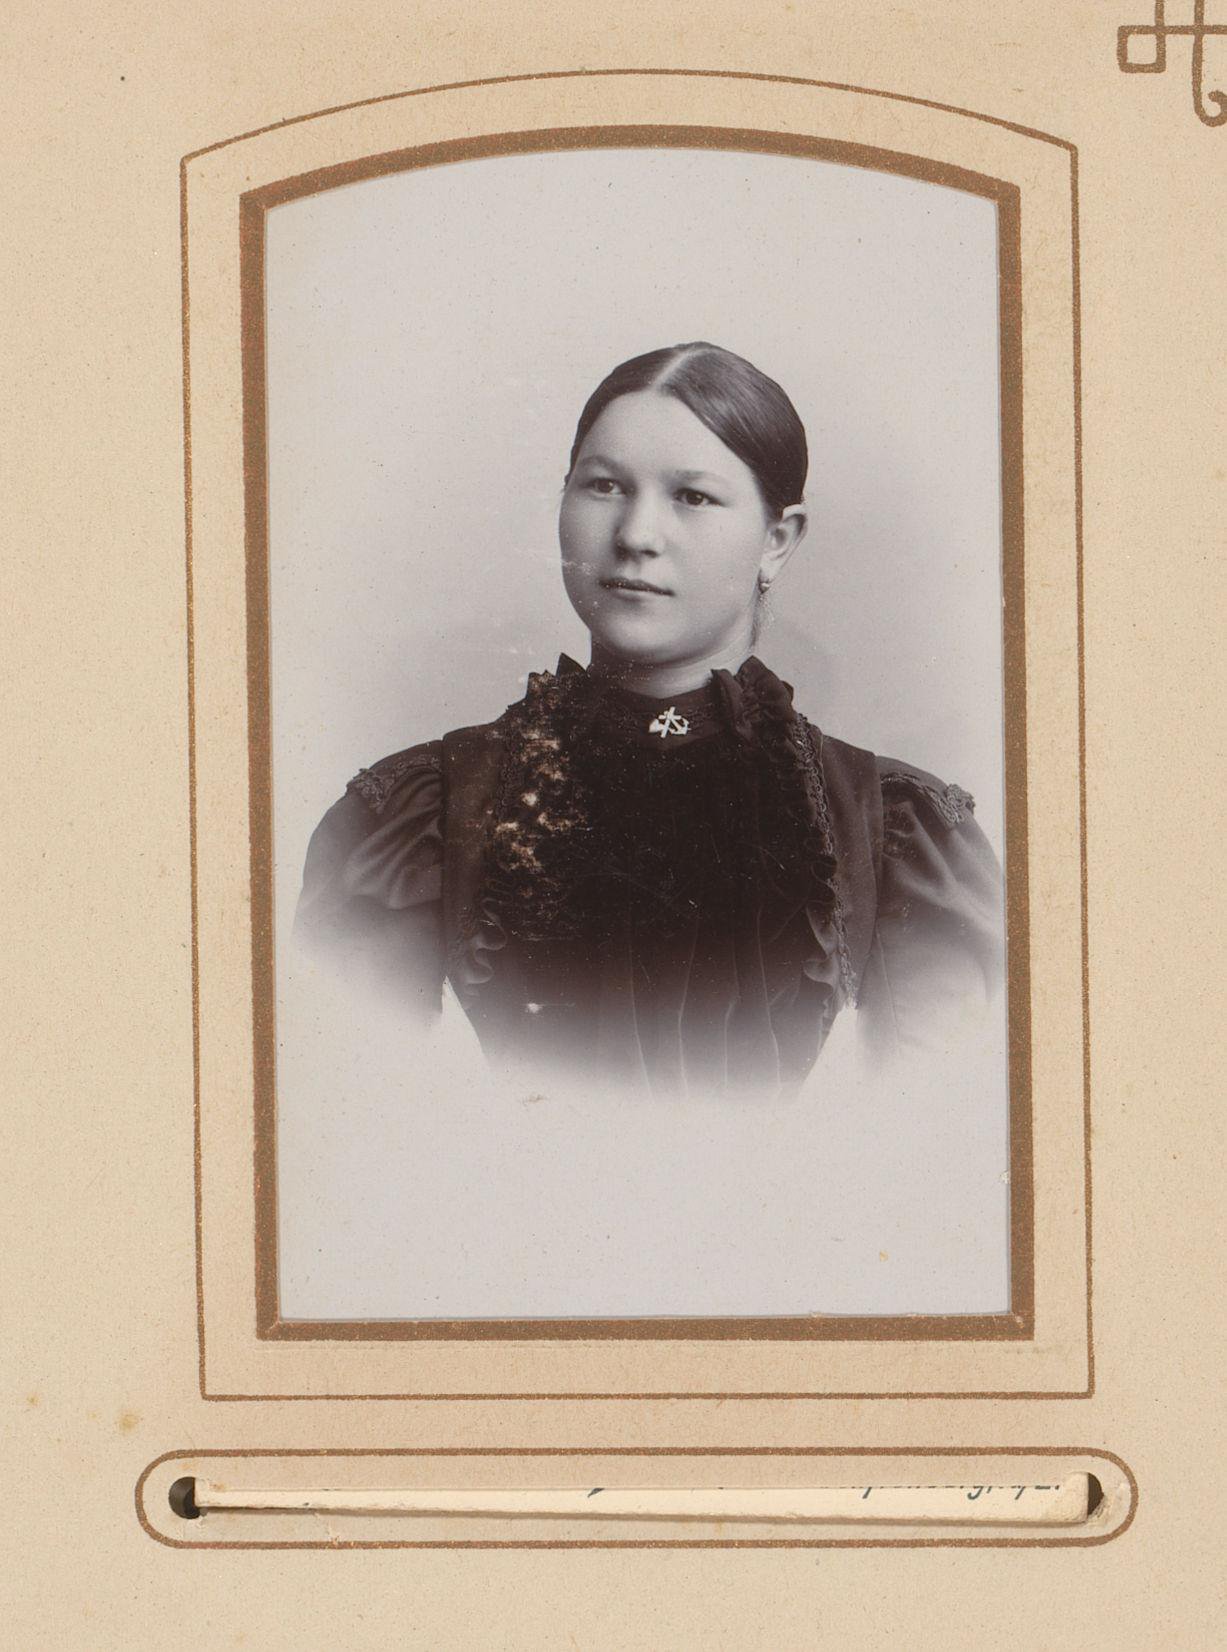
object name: photograph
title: Portret van een jonge vrouw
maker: hermann meyer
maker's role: fotograaf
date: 1881-1910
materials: cardboard, photographic support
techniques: collodion silver print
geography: senftenberg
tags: adolescent, young woman, maiden, historical persons - bb - woman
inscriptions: inscription: ‘Photographisches Atelier/ gegründet 1881/ Herm. Meyer/ Senftenberg N.L.’